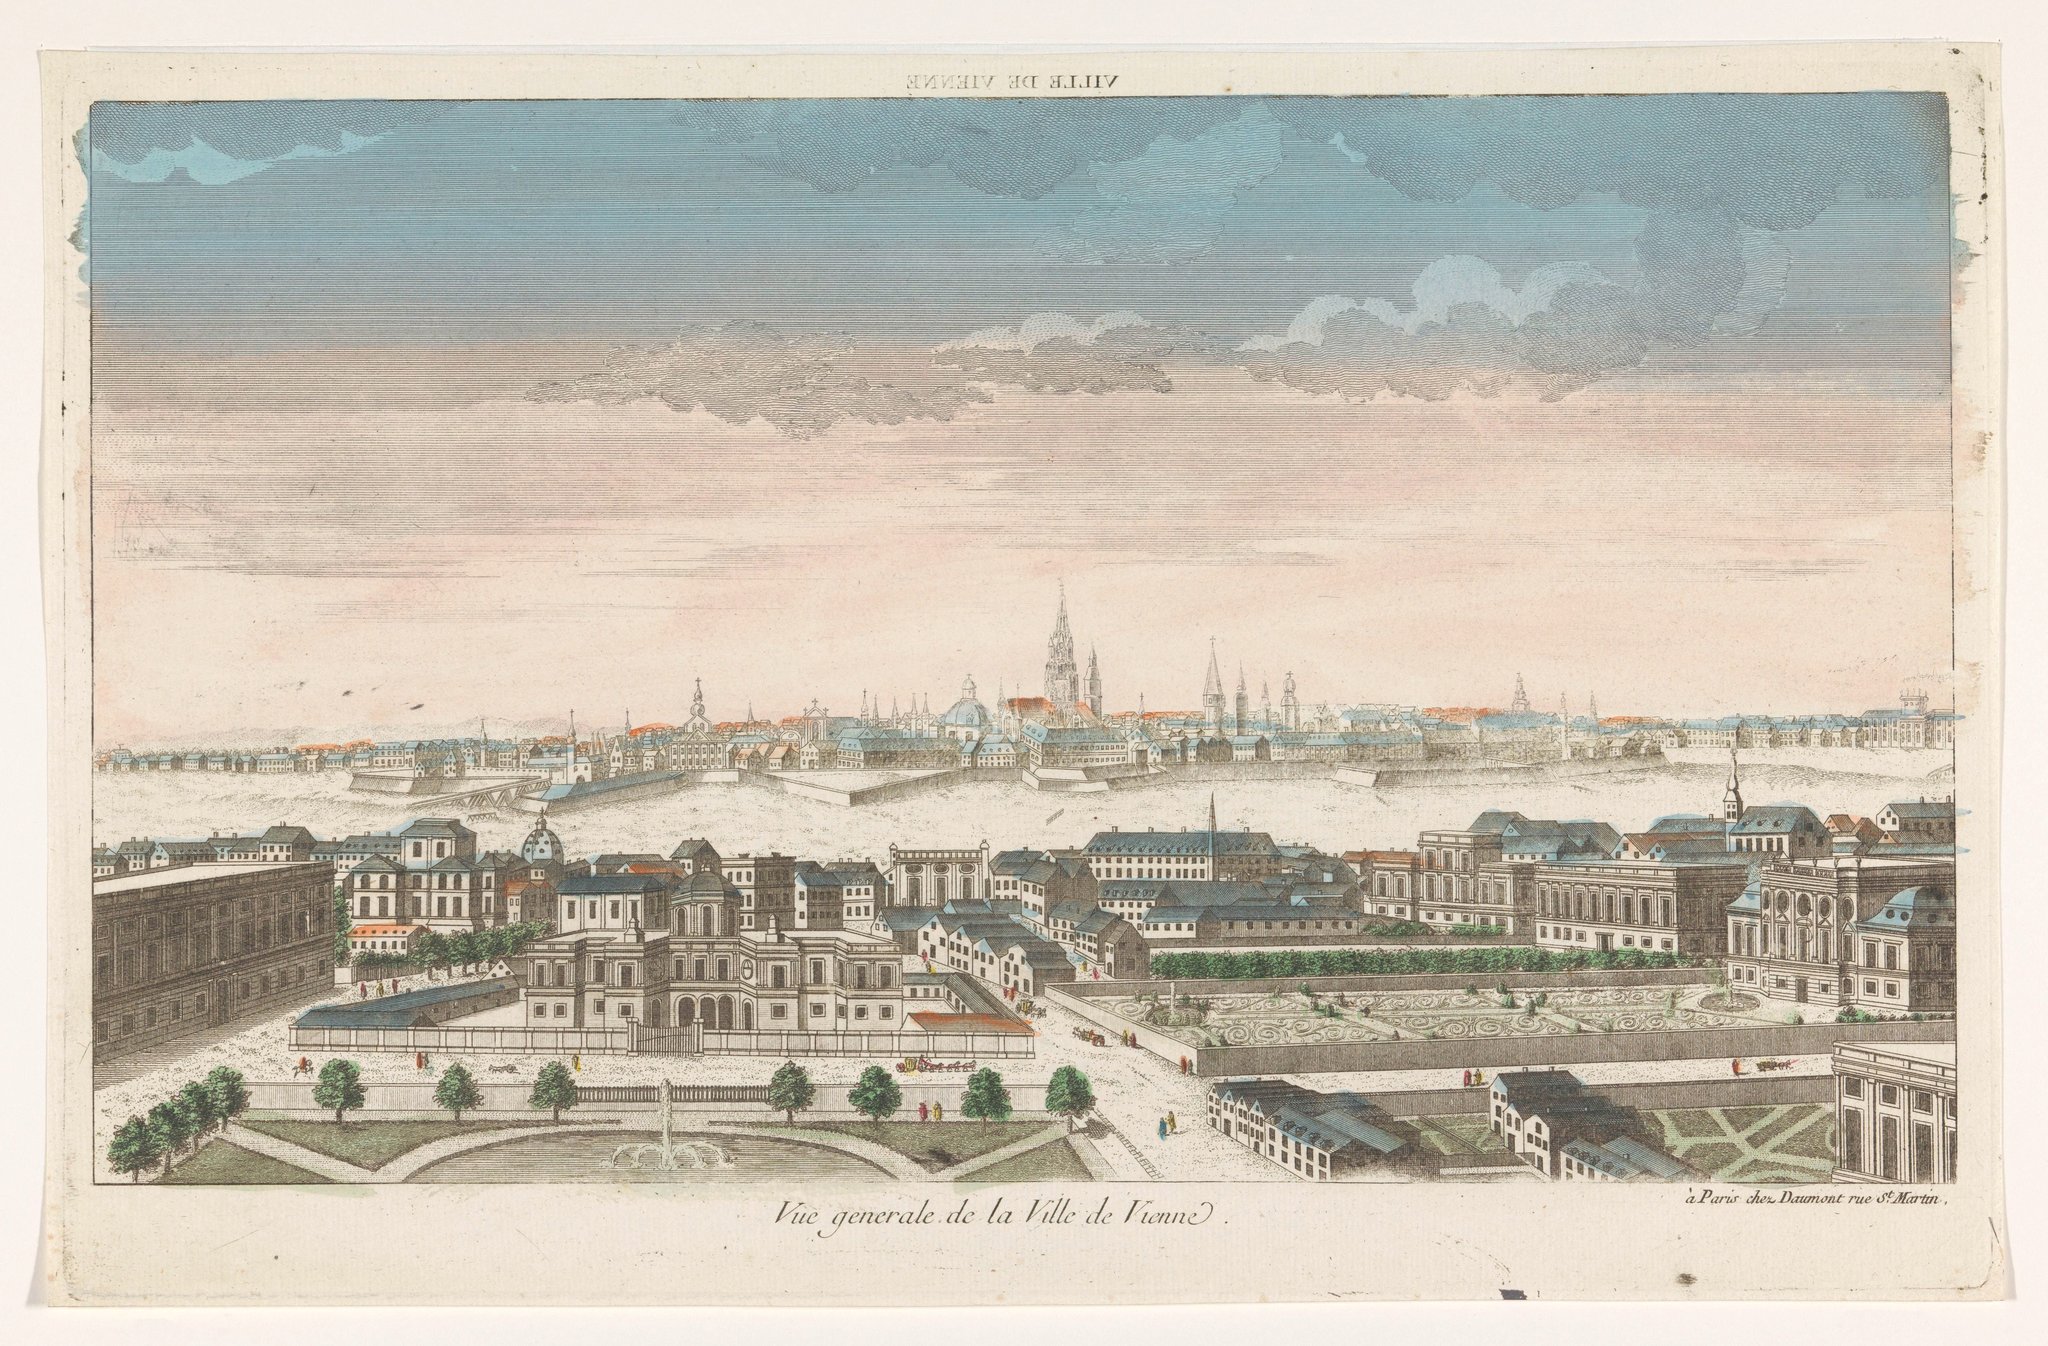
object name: print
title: Ville de Vienne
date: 1745-1775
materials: paper, watercolor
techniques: brush, etching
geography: france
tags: church (exterior), city-view in general; 'veduta' (+ city(-scape) with figures, staffage), canals, waters (in city) (+ city(-scape) with figures, staffage), vienna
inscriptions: collector's mark: Lugt 2233, watermark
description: In het midden de rivier de Donau. Op de achtergrond de Sint-Petruskerk en de Stephansdom.